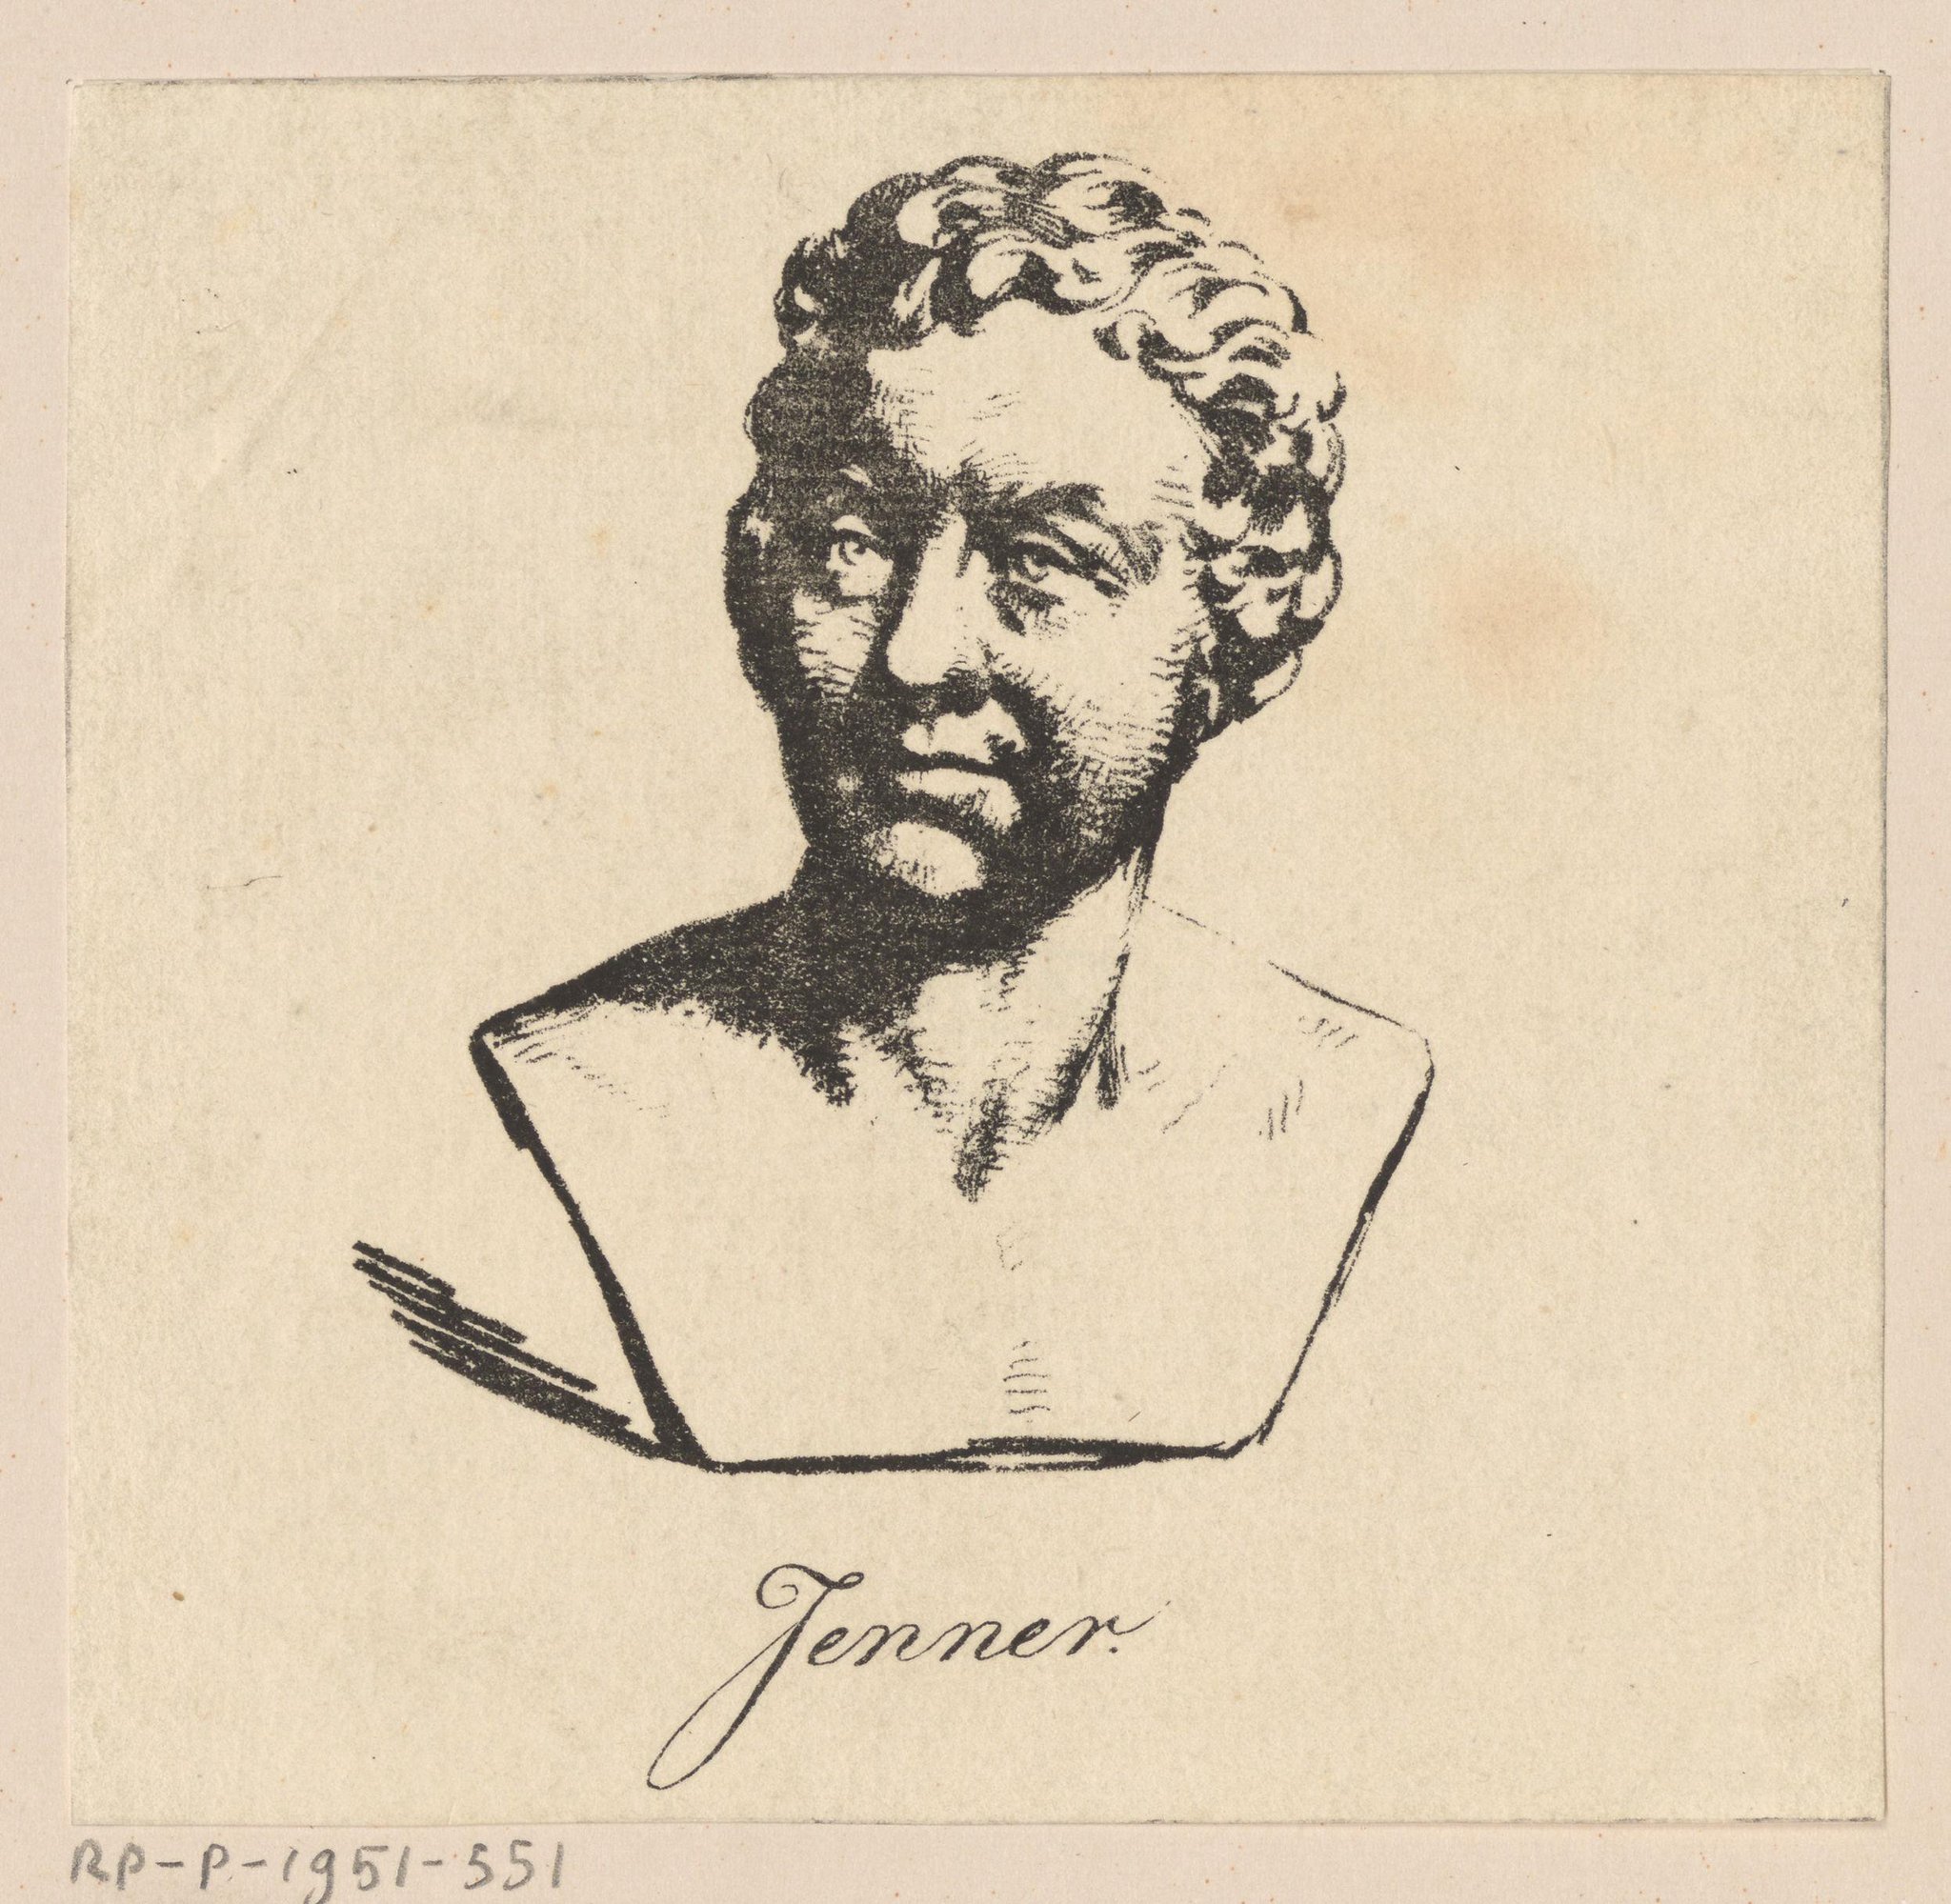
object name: print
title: Portret van Edward Jenner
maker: Anonymous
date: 1800-1899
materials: paper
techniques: lithograph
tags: historical persons, physician, doctor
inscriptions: collector's mark: Lugt 2228